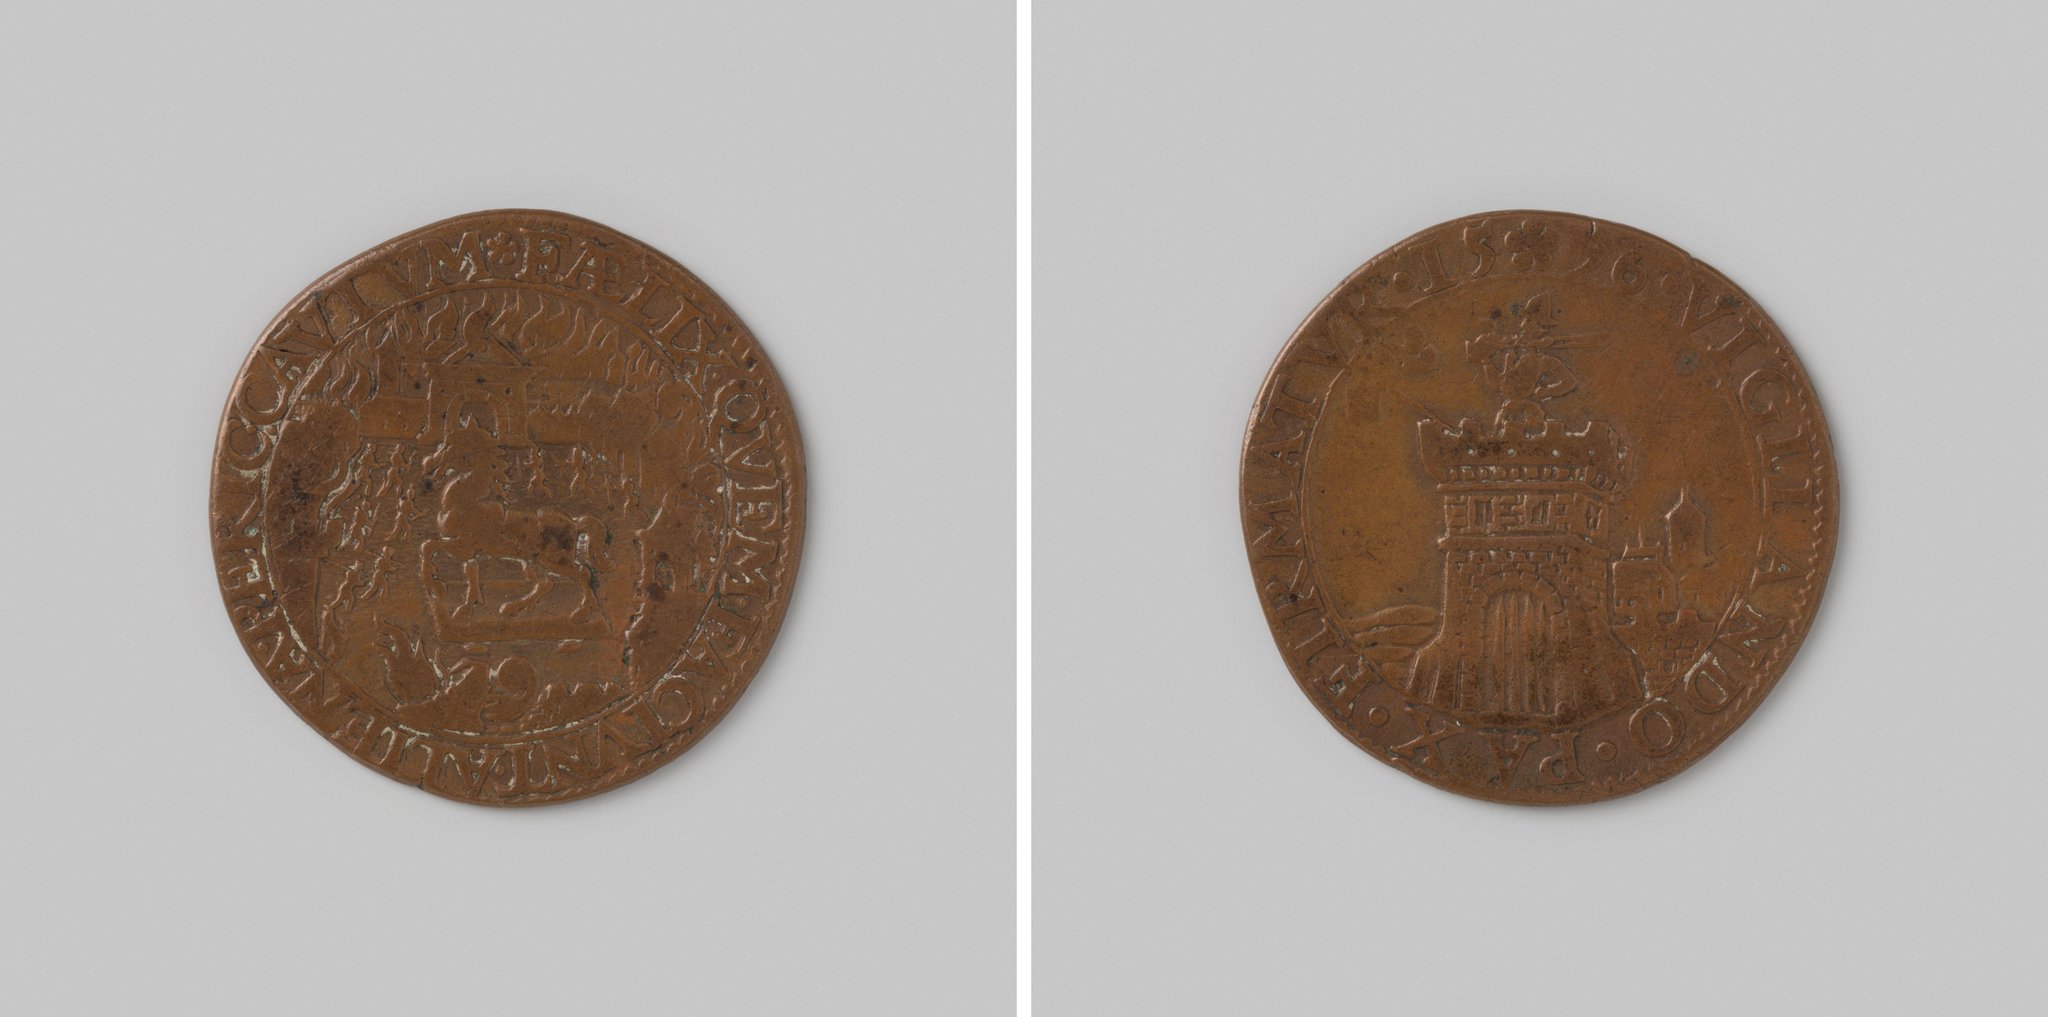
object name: jeton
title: Rekenpenning uit Dordrecht op het afslaan van bemiddeling door de Duitse Keizer 1596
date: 1596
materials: copper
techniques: striking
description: Koperen penning, op de voorzijde het Paard van Troje in een brandende stad, met omschrift, op de keerzijde een soldaat op een wachttoren, met omschrift.